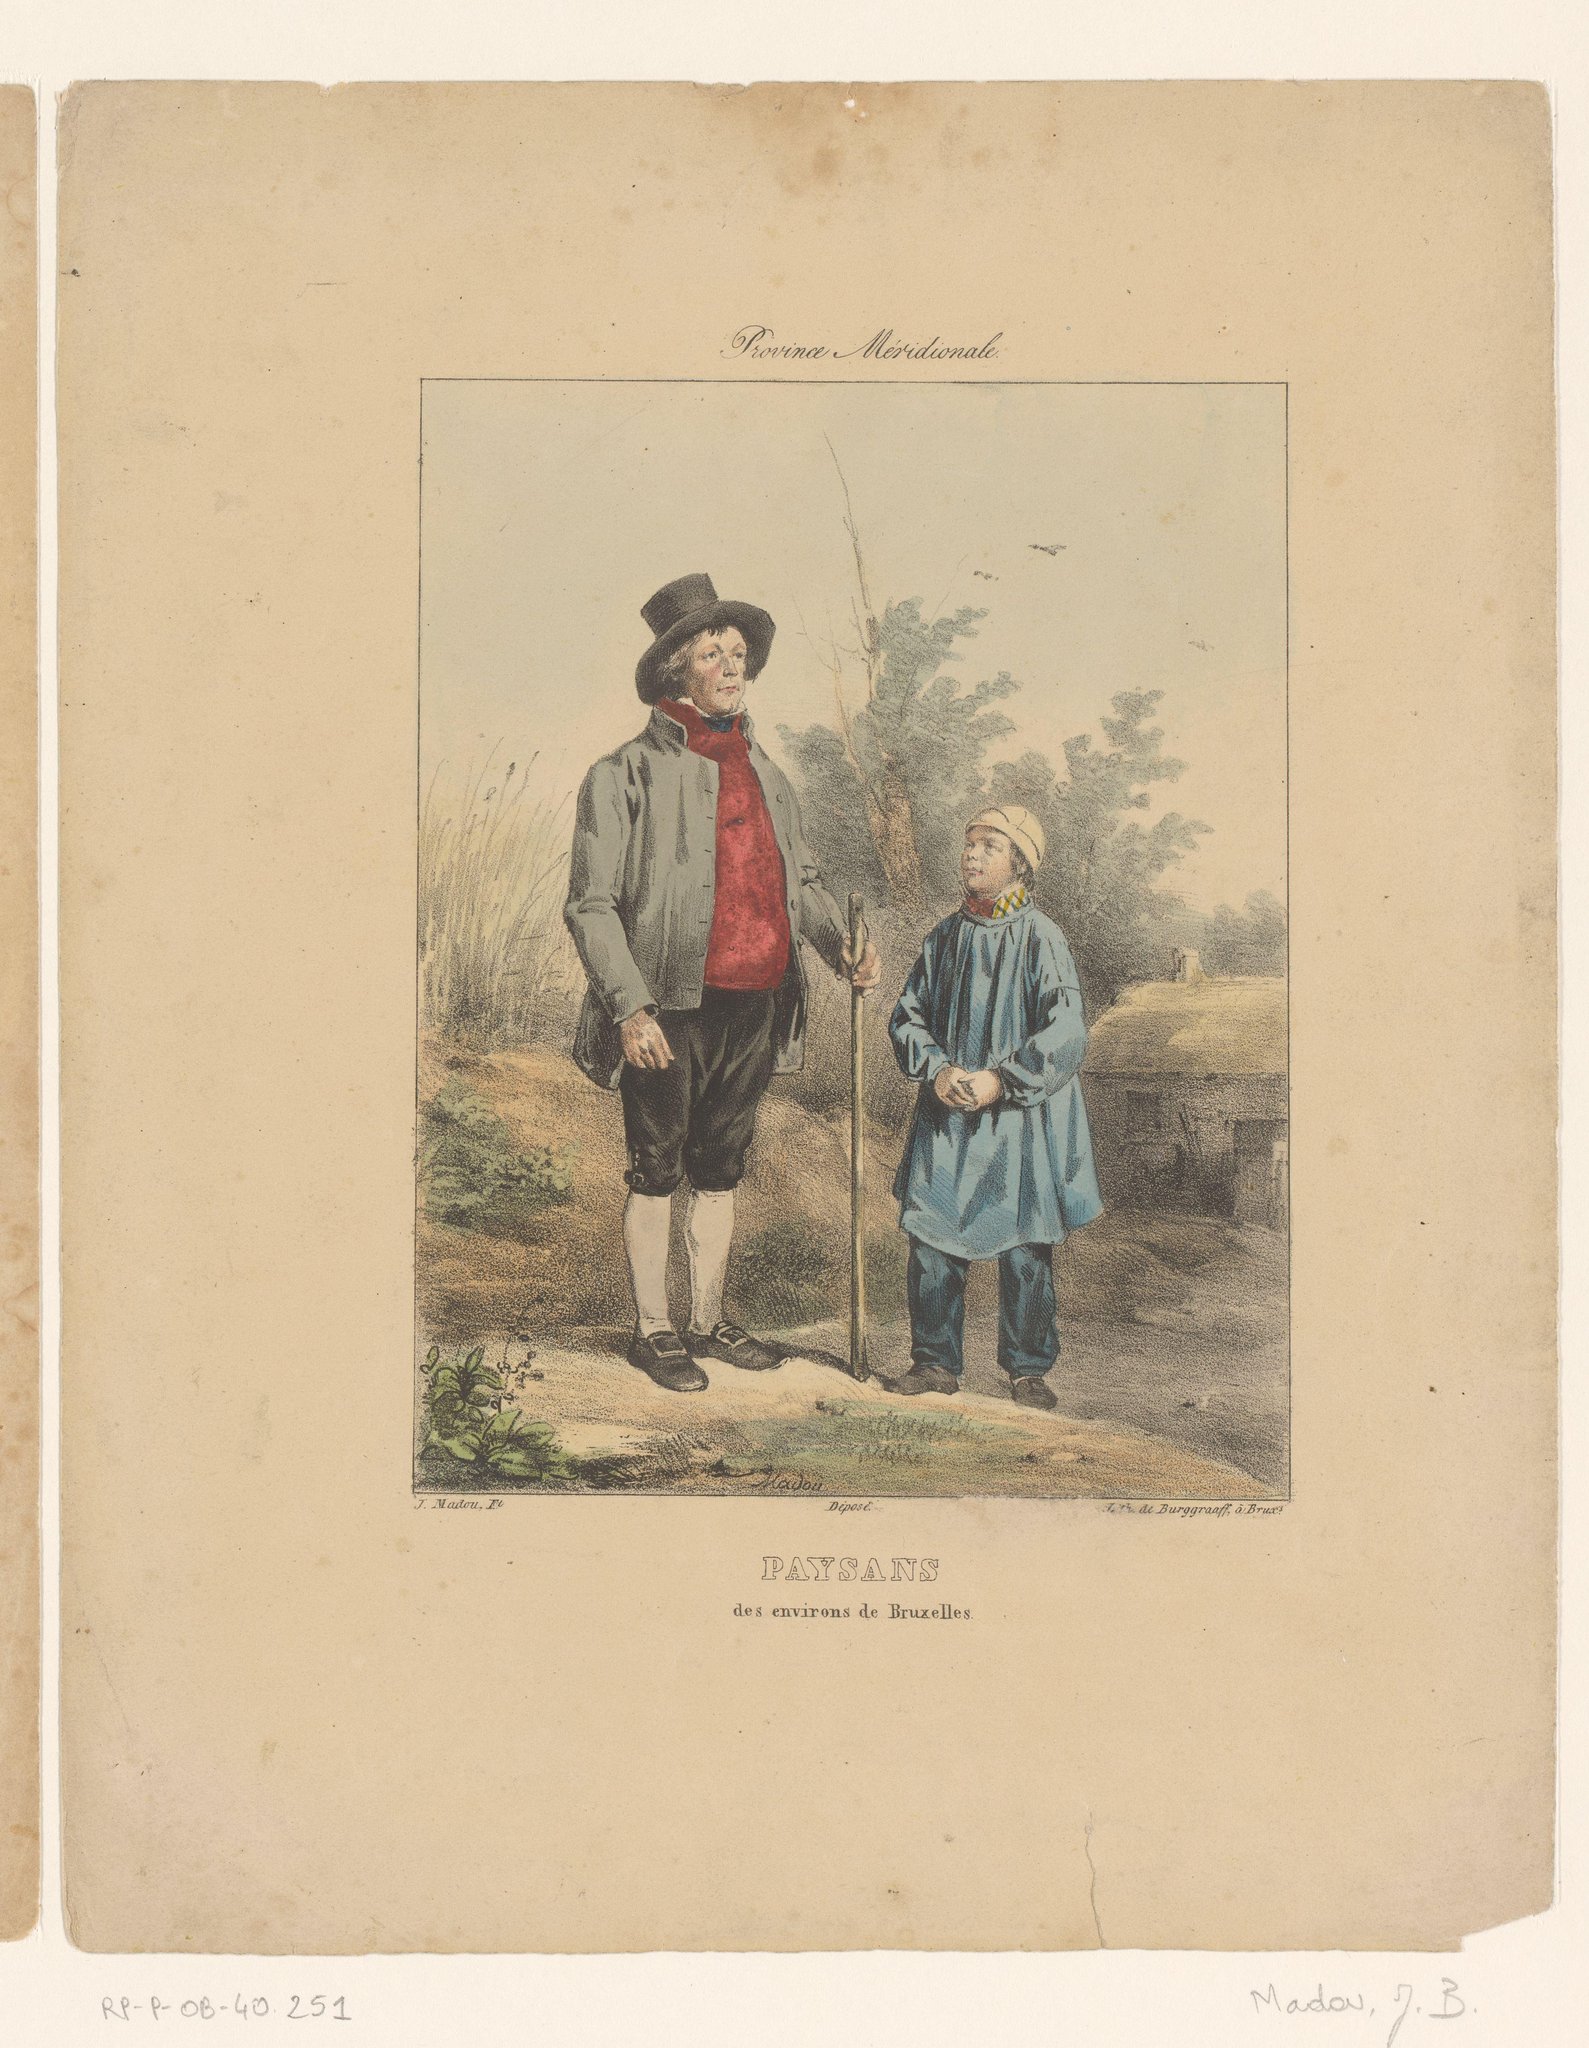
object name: print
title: Collection de costumes du peuple des provinces de la Belgique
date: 1825-1835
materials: paper, pencil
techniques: hand coloring, lithograph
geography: brussels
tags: farmers, folk costume, regional costume, father and son(s) (family group)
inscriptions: : ‘Déposé’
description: Van den Burggraaff wilde een serie (twintig afleveringen met telkens vier platen) uitgeven met kostuums uit alle provincies van Nederland en België onder de titel 'Costumes du peuple de toutes les provinces des Pays-Bas'. Hij begint met deze serie in 1825 en eindigt hiermee bij de dertiende aflevering in 1830. Omdat in 1830 België zicht afsplitst van Nederland geeft hij de prenten daarna apart uit onder de titels 'Costumes de peuple Hollandais' en 'Collection de costumes du peuple des provinces de la Belgique' (1835).